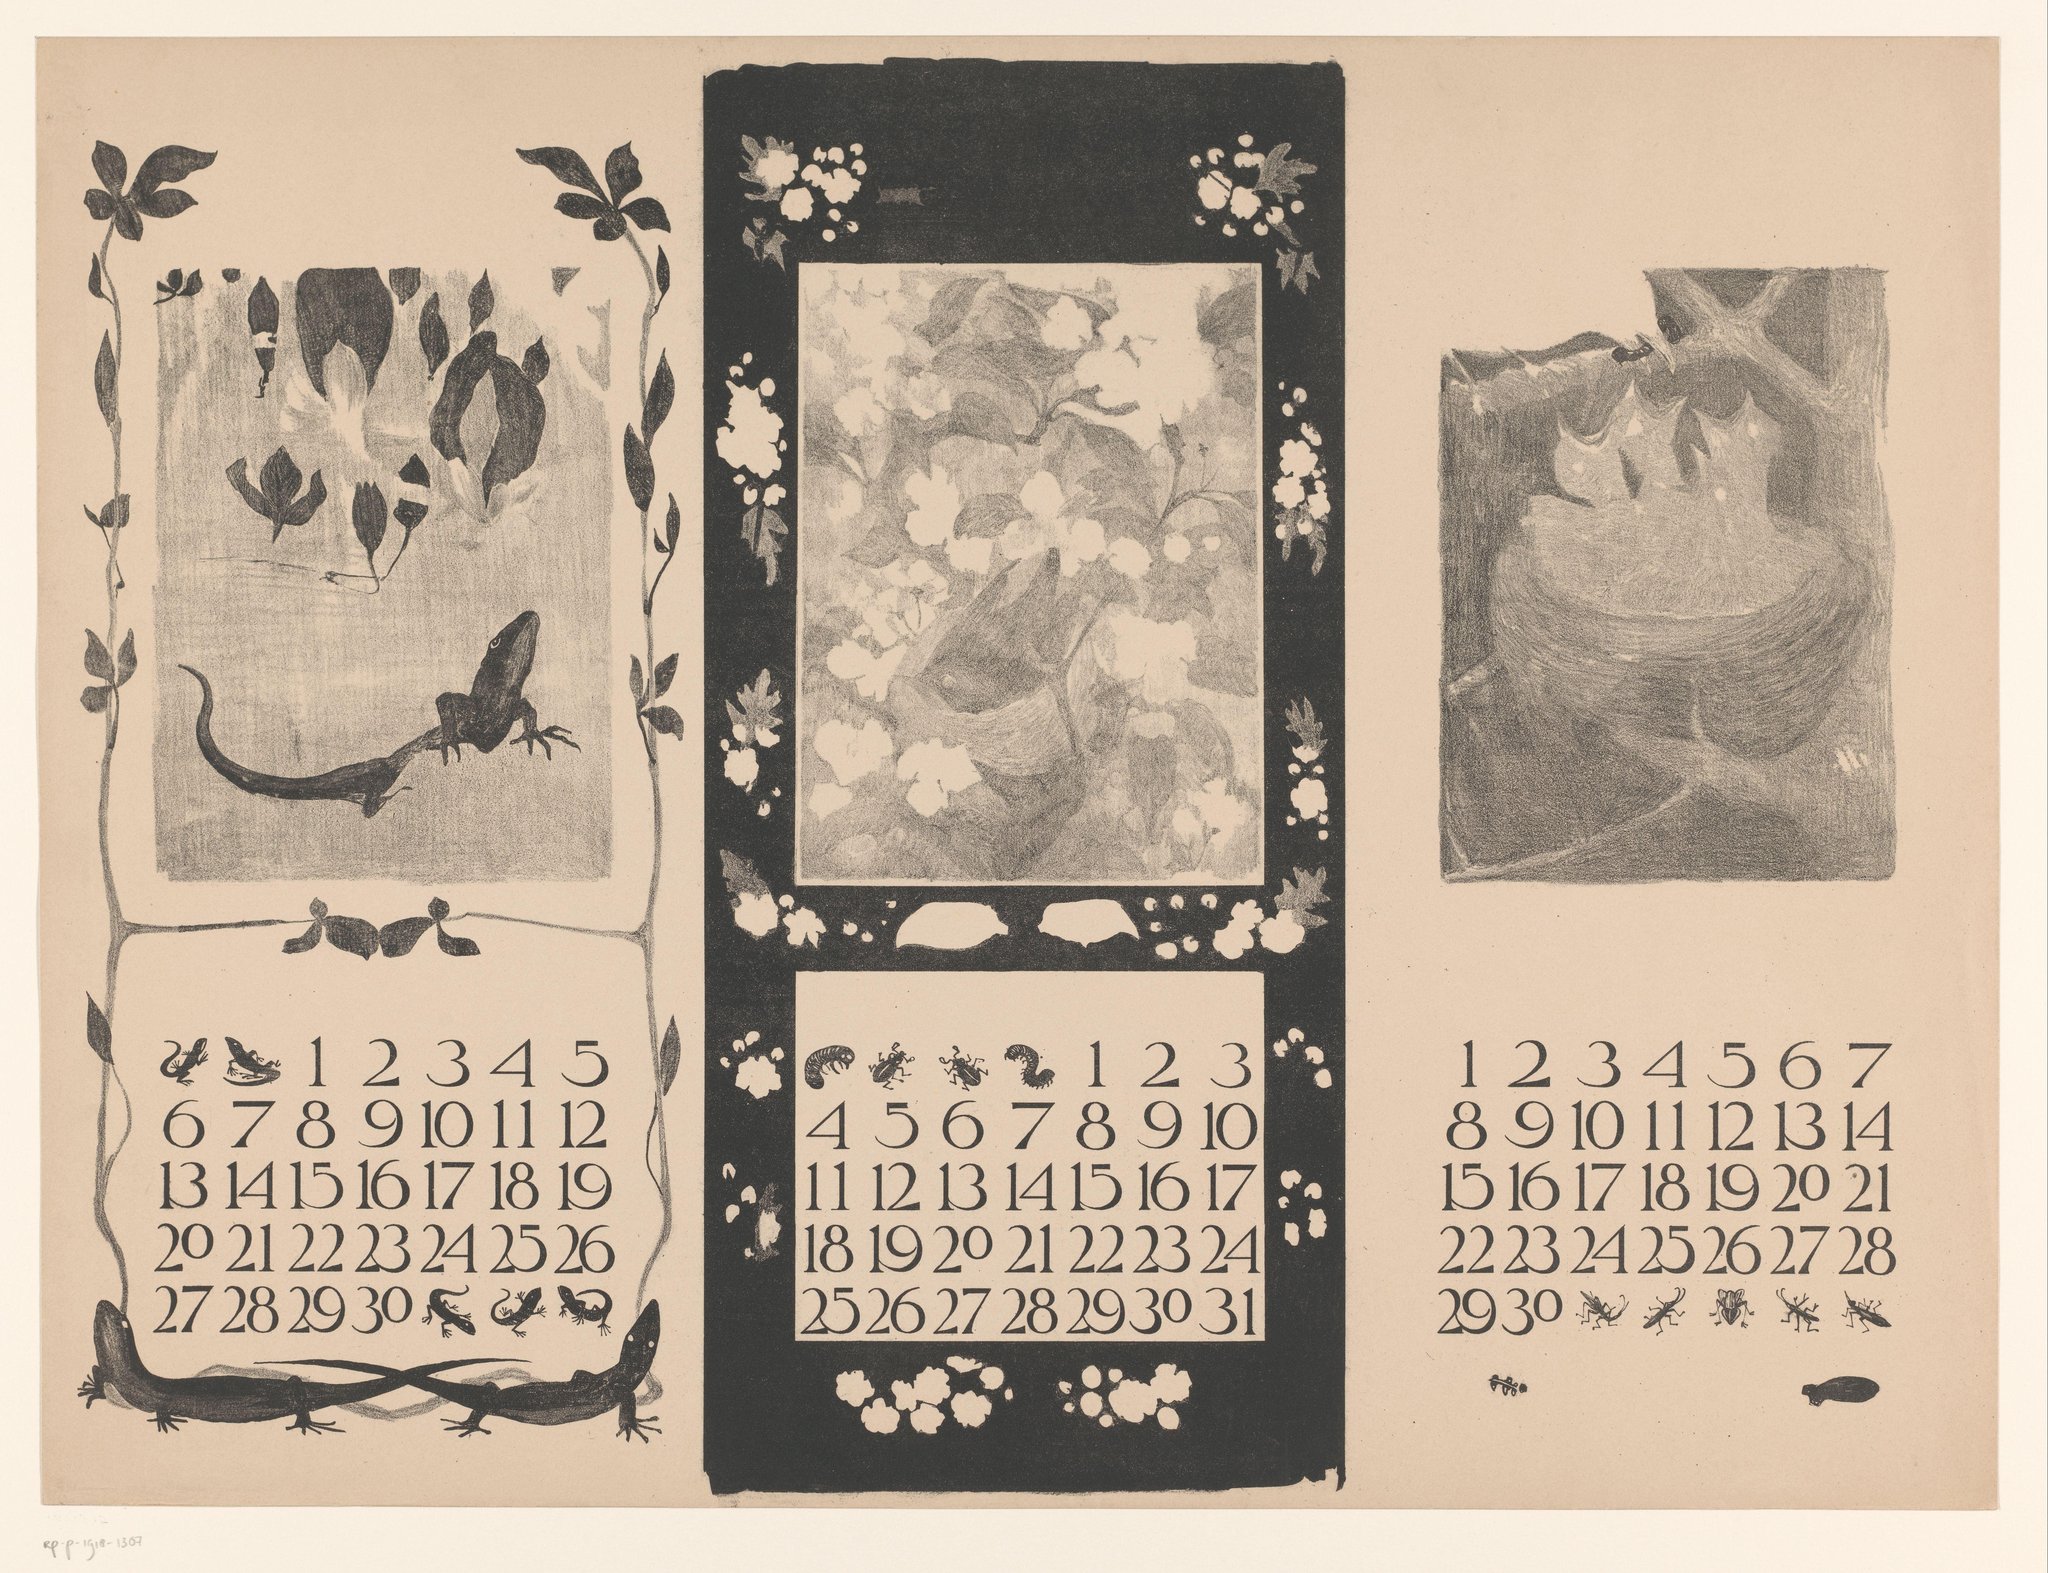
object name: calendar leaf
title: Kalenderbladen van april, mei en juni, met hagedis en vogels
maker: theo van hoytema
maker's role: draughtsman, painter, print maker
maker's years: 1863-1917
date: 1901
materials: paper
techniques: lithograph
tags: calendar, almanac, lizards, birds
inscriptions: collector's mark: Lugt 2233